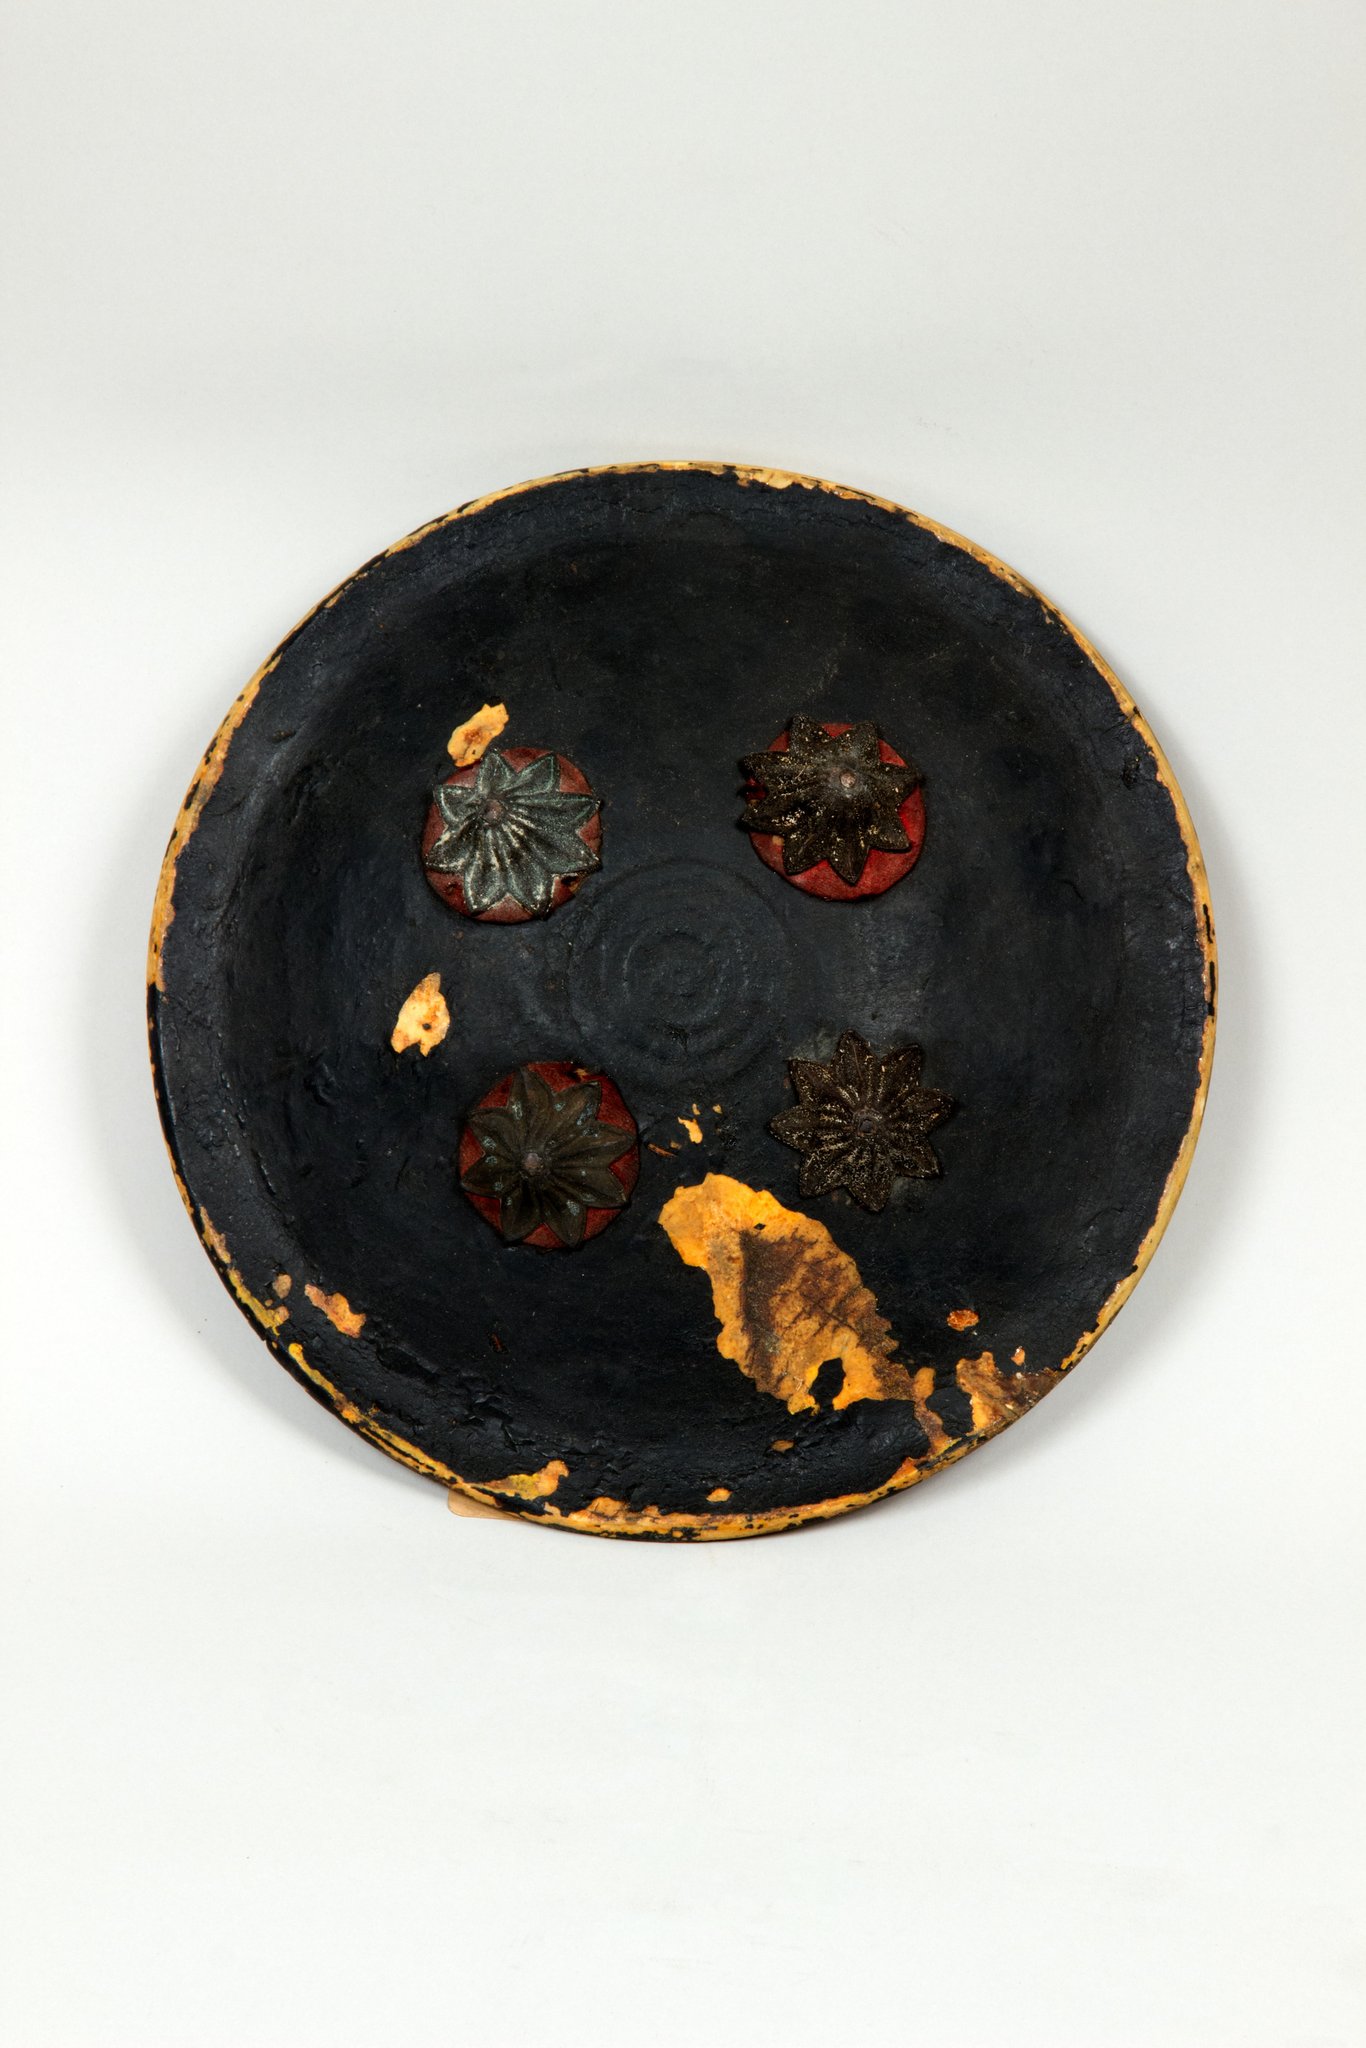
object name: shield dhàl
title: Shield (Dhàl)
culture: indian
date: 1701-1900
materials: copper alloy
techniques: polychromy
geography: india